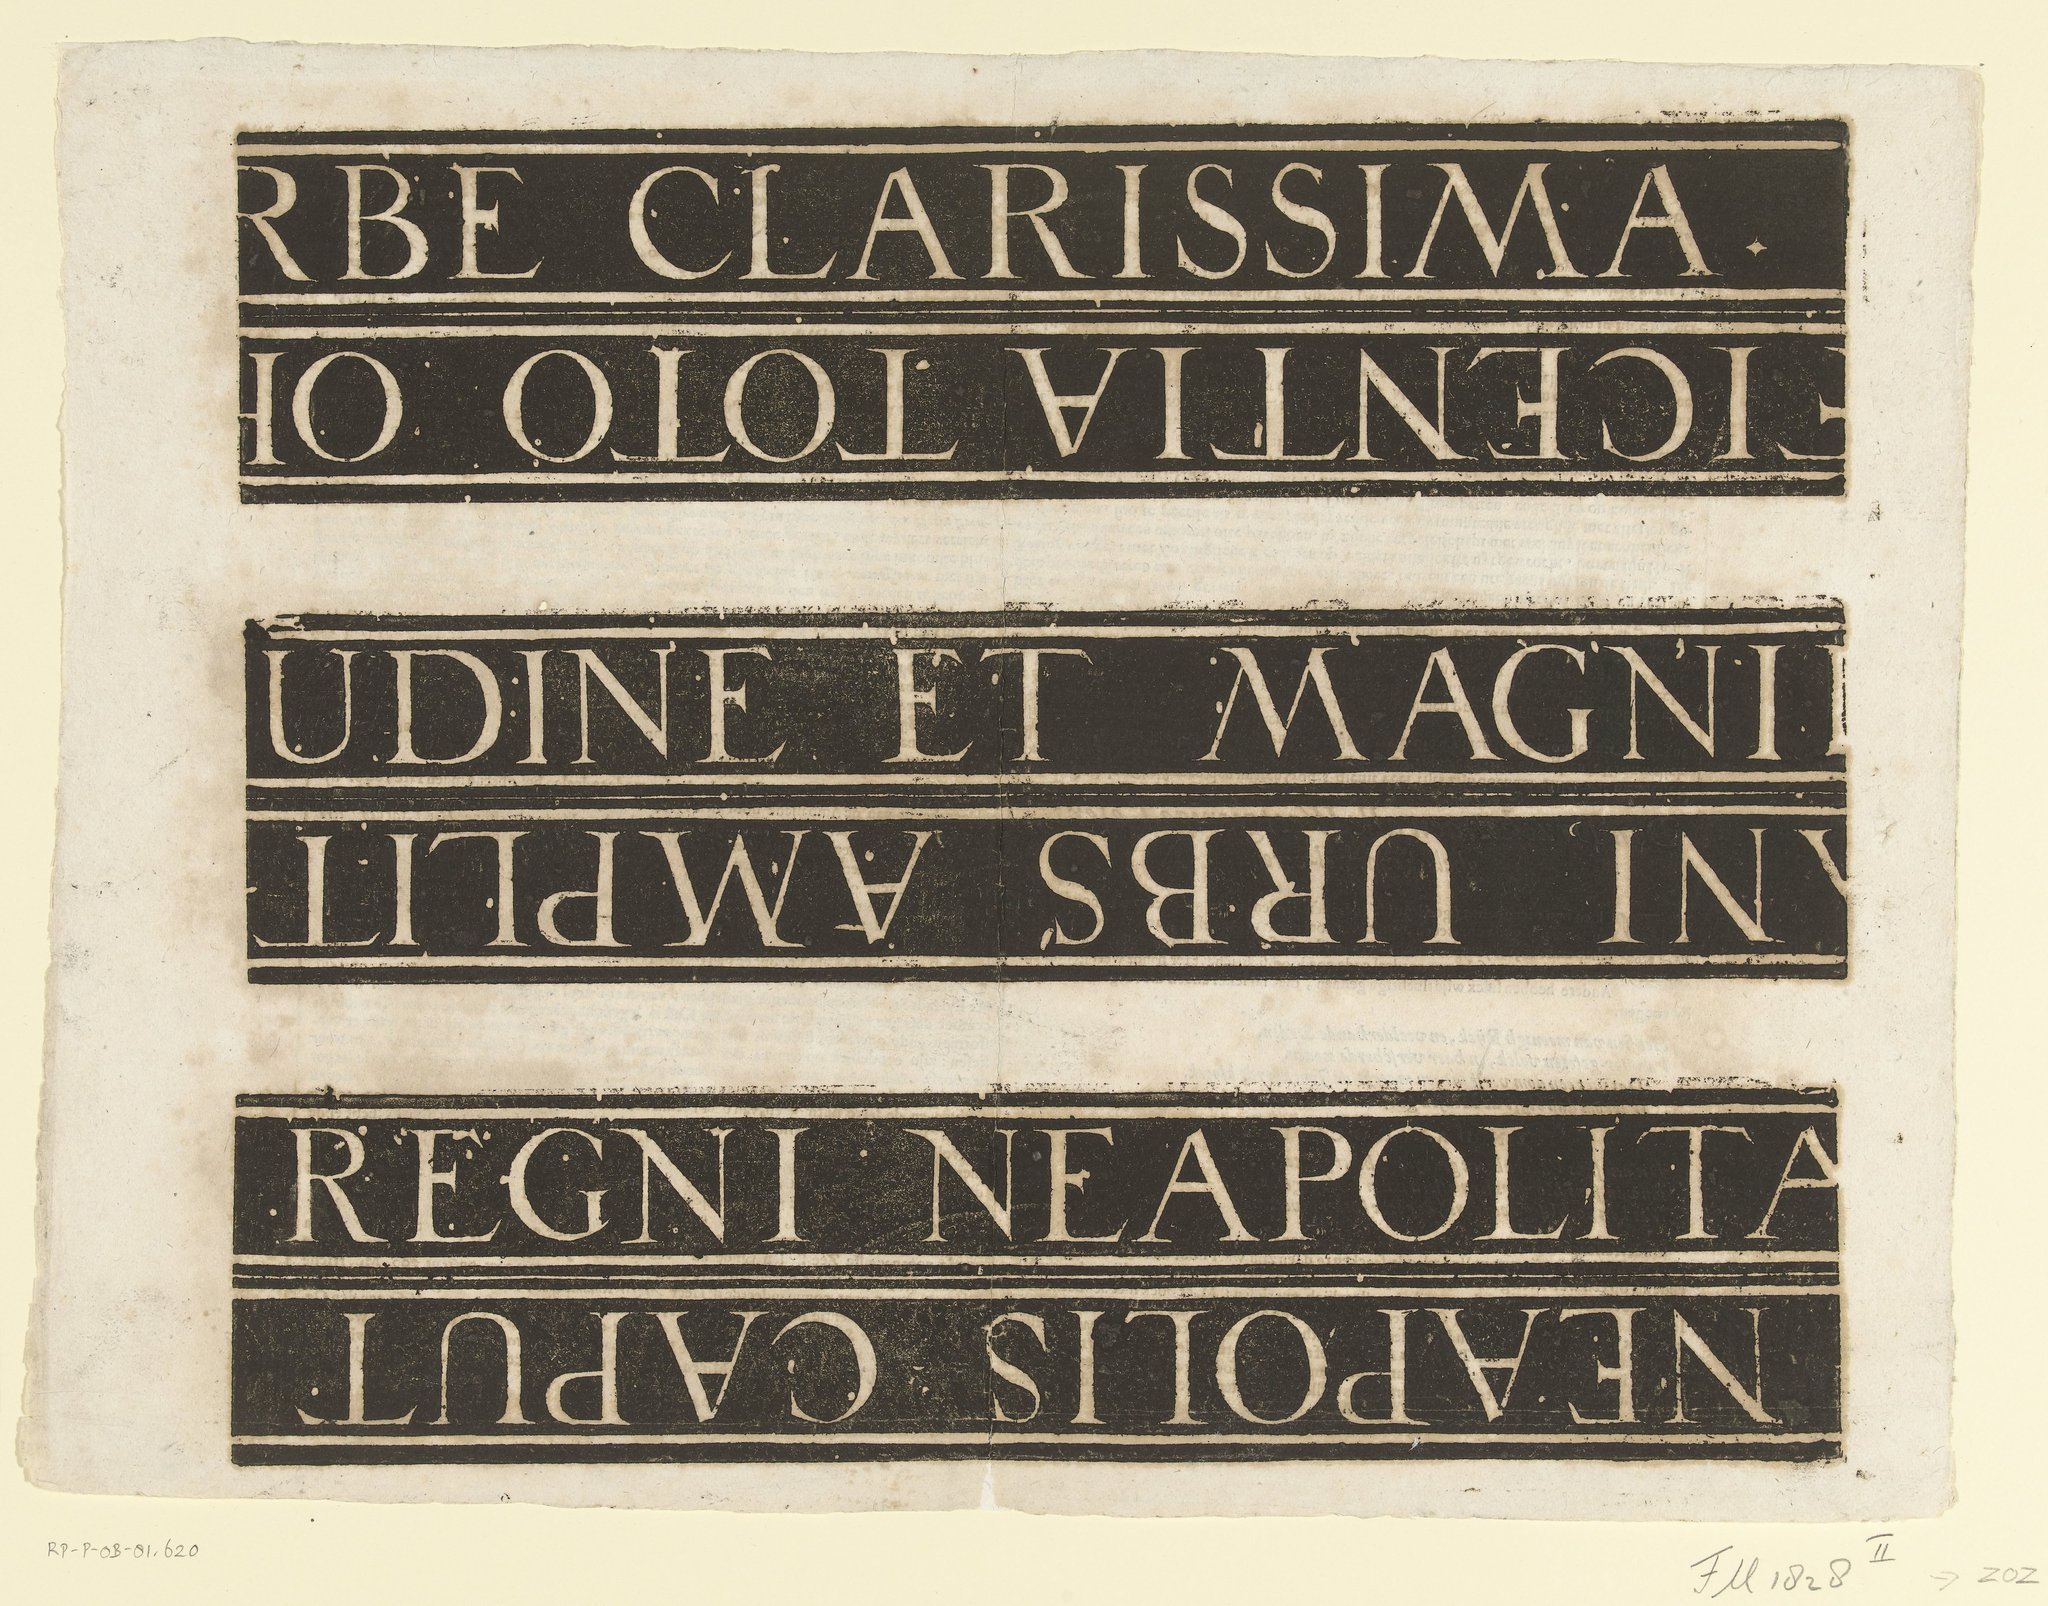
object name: text sheet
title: Het paleis van de sultan van Marokko (tekstblad 1), 1640-1641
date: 1646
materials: paper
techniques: letterpress printing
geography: the hague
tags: sultan, mohammed esh sheikh es seghir (sultan van marokko), antonius de liedekercke, paleis el-badi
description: Los exemplaar van het tekstblad bij de prent met het gezicht op het paleis van de sultan van Marokko in Marrakesh, ten tijde van het bezoek door het gezantschap op een handelsmissie namens de Staten-Generaal onder leiding van Antonius de Liedekercke, van november 1640 tot april 1641. Latere uitgave van het eerste tekstblad met vier blokken tekst in het Nederlands gemerkt A-D. Gedrukt op de achterkant van een blad met de Latijnse titel in zes onversneden stroken in houtsnede behorend bij een profiel van Napels, volgens Muller een uitgave van C.J. Visscher.